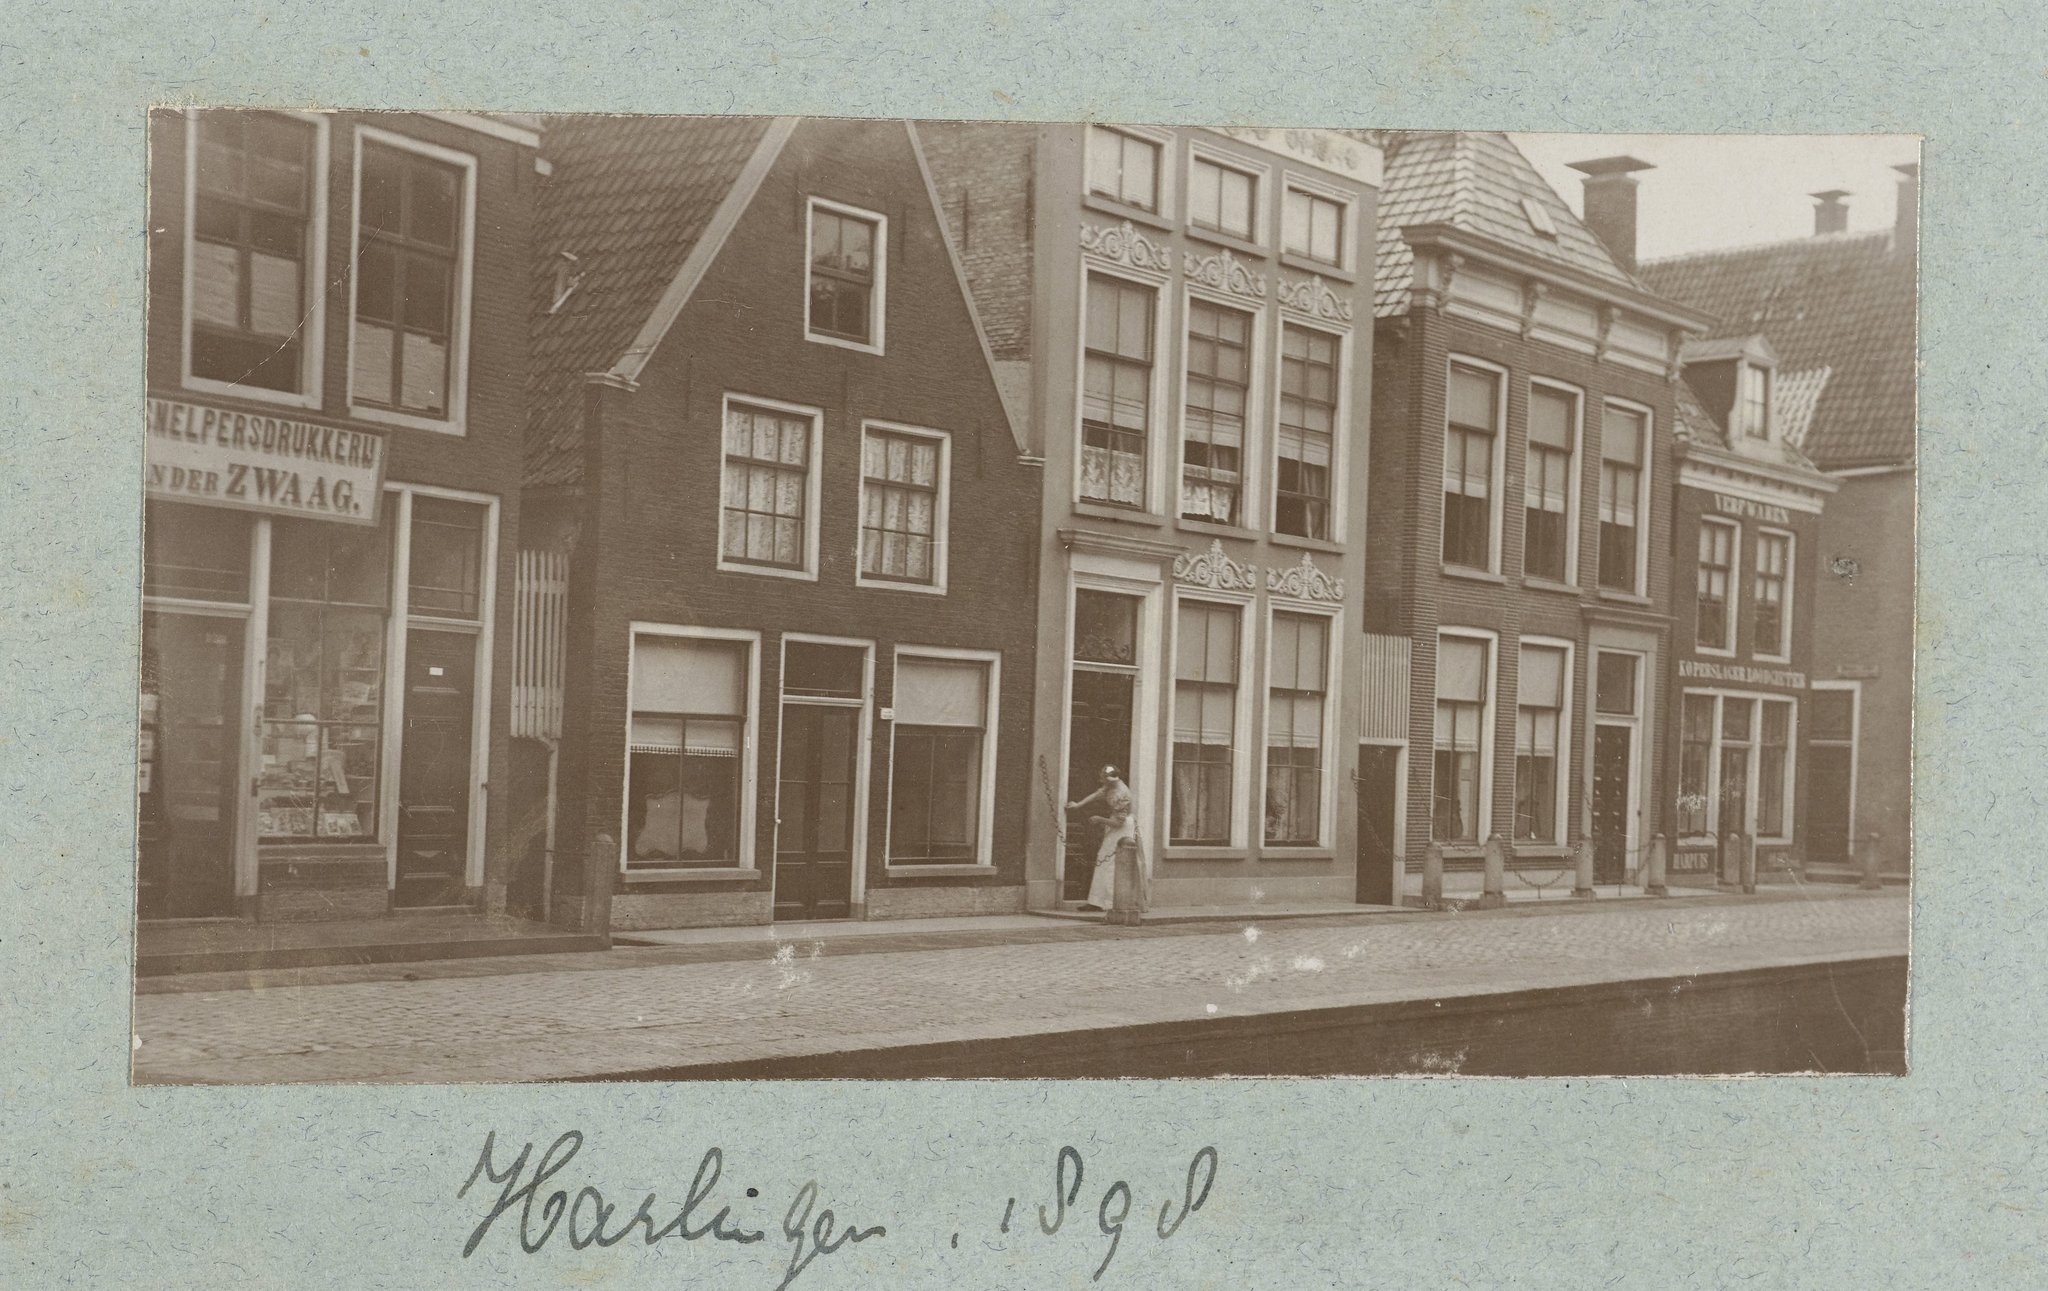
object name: photograph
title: Harlingen, 1898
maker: frits freerks fontein fz.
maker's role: fotograaf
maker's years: 1882-1928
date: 1898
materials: cardboard, paper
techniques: gelatin silver print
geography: netherlands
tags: harlingen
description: Gezicht op huizen aan de Voorstraat te Harlingen, waaronder snelpersdrukkerij Van der Zwaag. Foto uit album 'Photographieën".